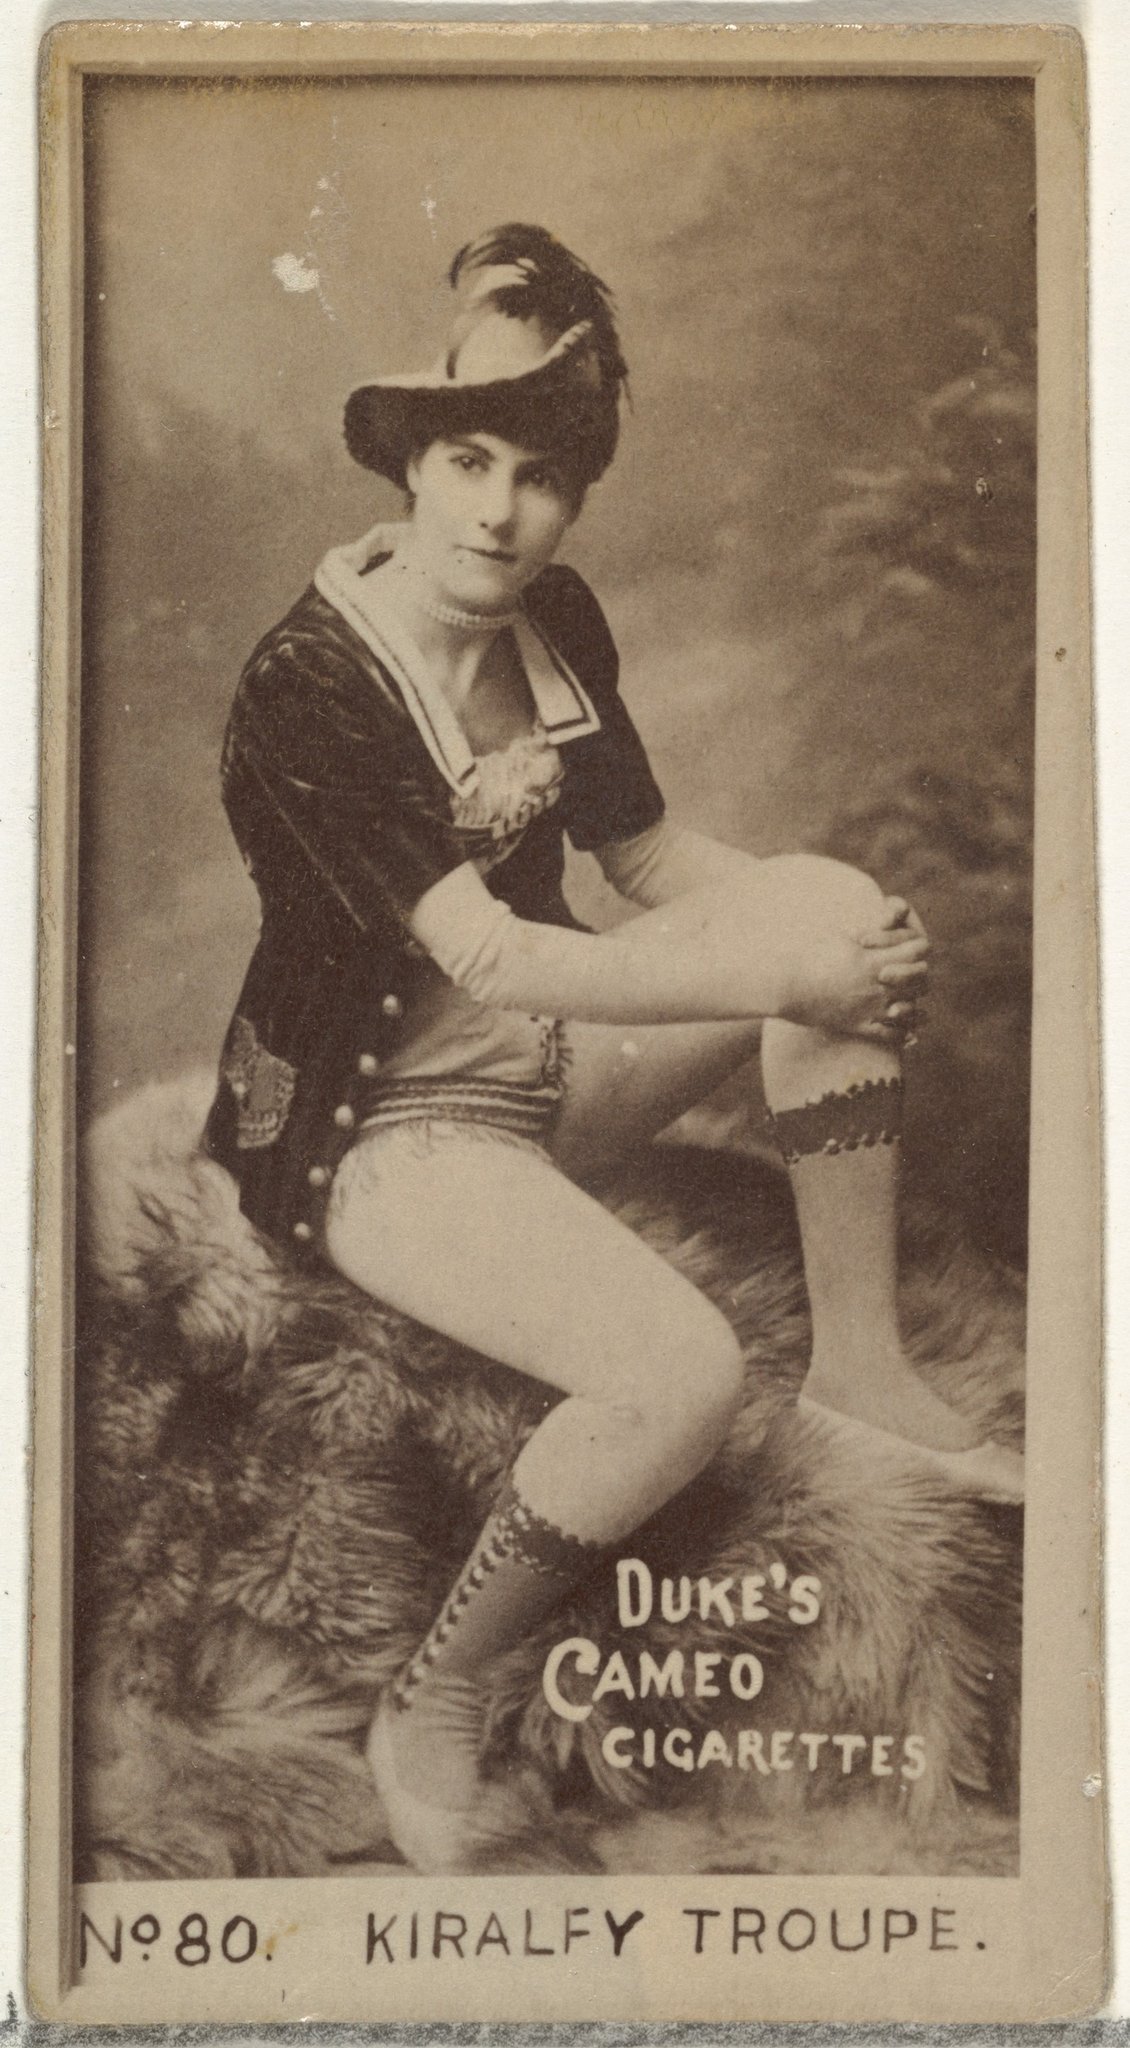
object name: photograph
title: Card Number 80, Kiralfy Troupe, from the Actors and Actresses series (N145-4) issued by Duke Sons & Co. to promote Cameo Cigarettes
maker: w. duke, sons & co.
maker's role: publisher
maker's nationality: american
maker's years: 1870-1920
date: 1880-1889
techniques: albumen silver print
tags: portraits,women,actresses